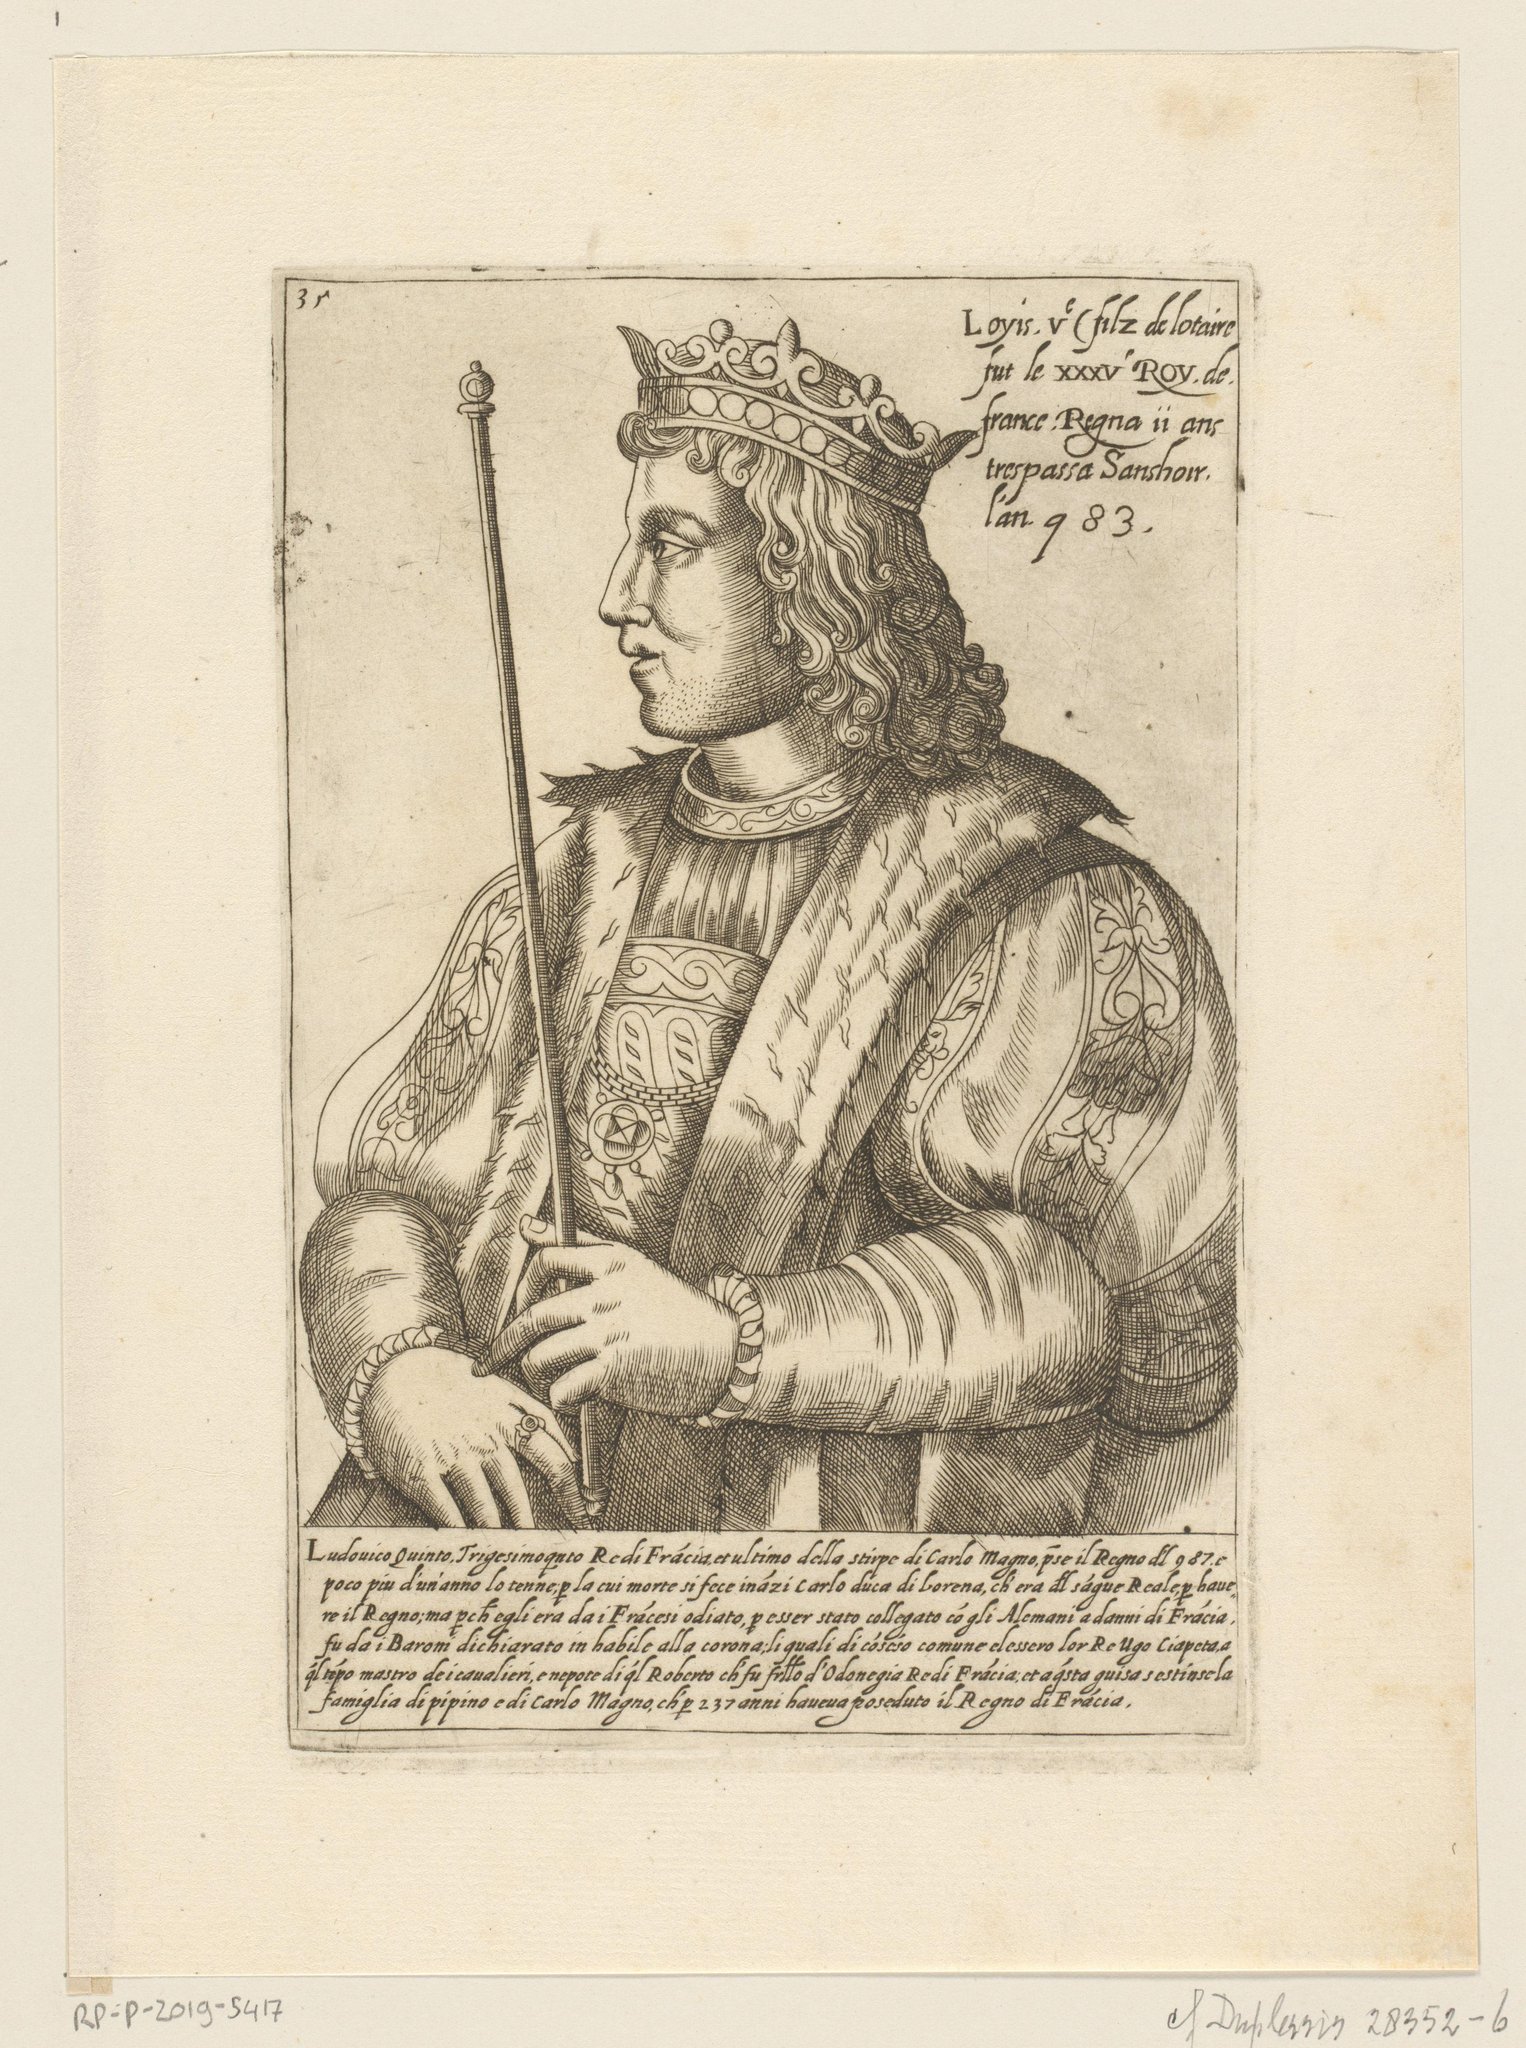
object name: book illustration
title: Portret van Lodewijk V, koning van West-Francië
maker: Anonymous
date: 1588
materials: paper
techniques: engraving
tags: crown (symbol of sovereignty), sceptre, staff (symbol of sovereignty), historical persons, king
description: Prent voor het eerst gebruikt in: Cronica Breve de i fatti illustri de're di Francia, con le loro effigie dal naturale cominciando da Faramondo (...). Venetië: Bernardo Giunti, 1588. Prent in ieder geval ook gebruikt in de editie van 1590 en mogelijk ook in een Franse uitgave van 1597.